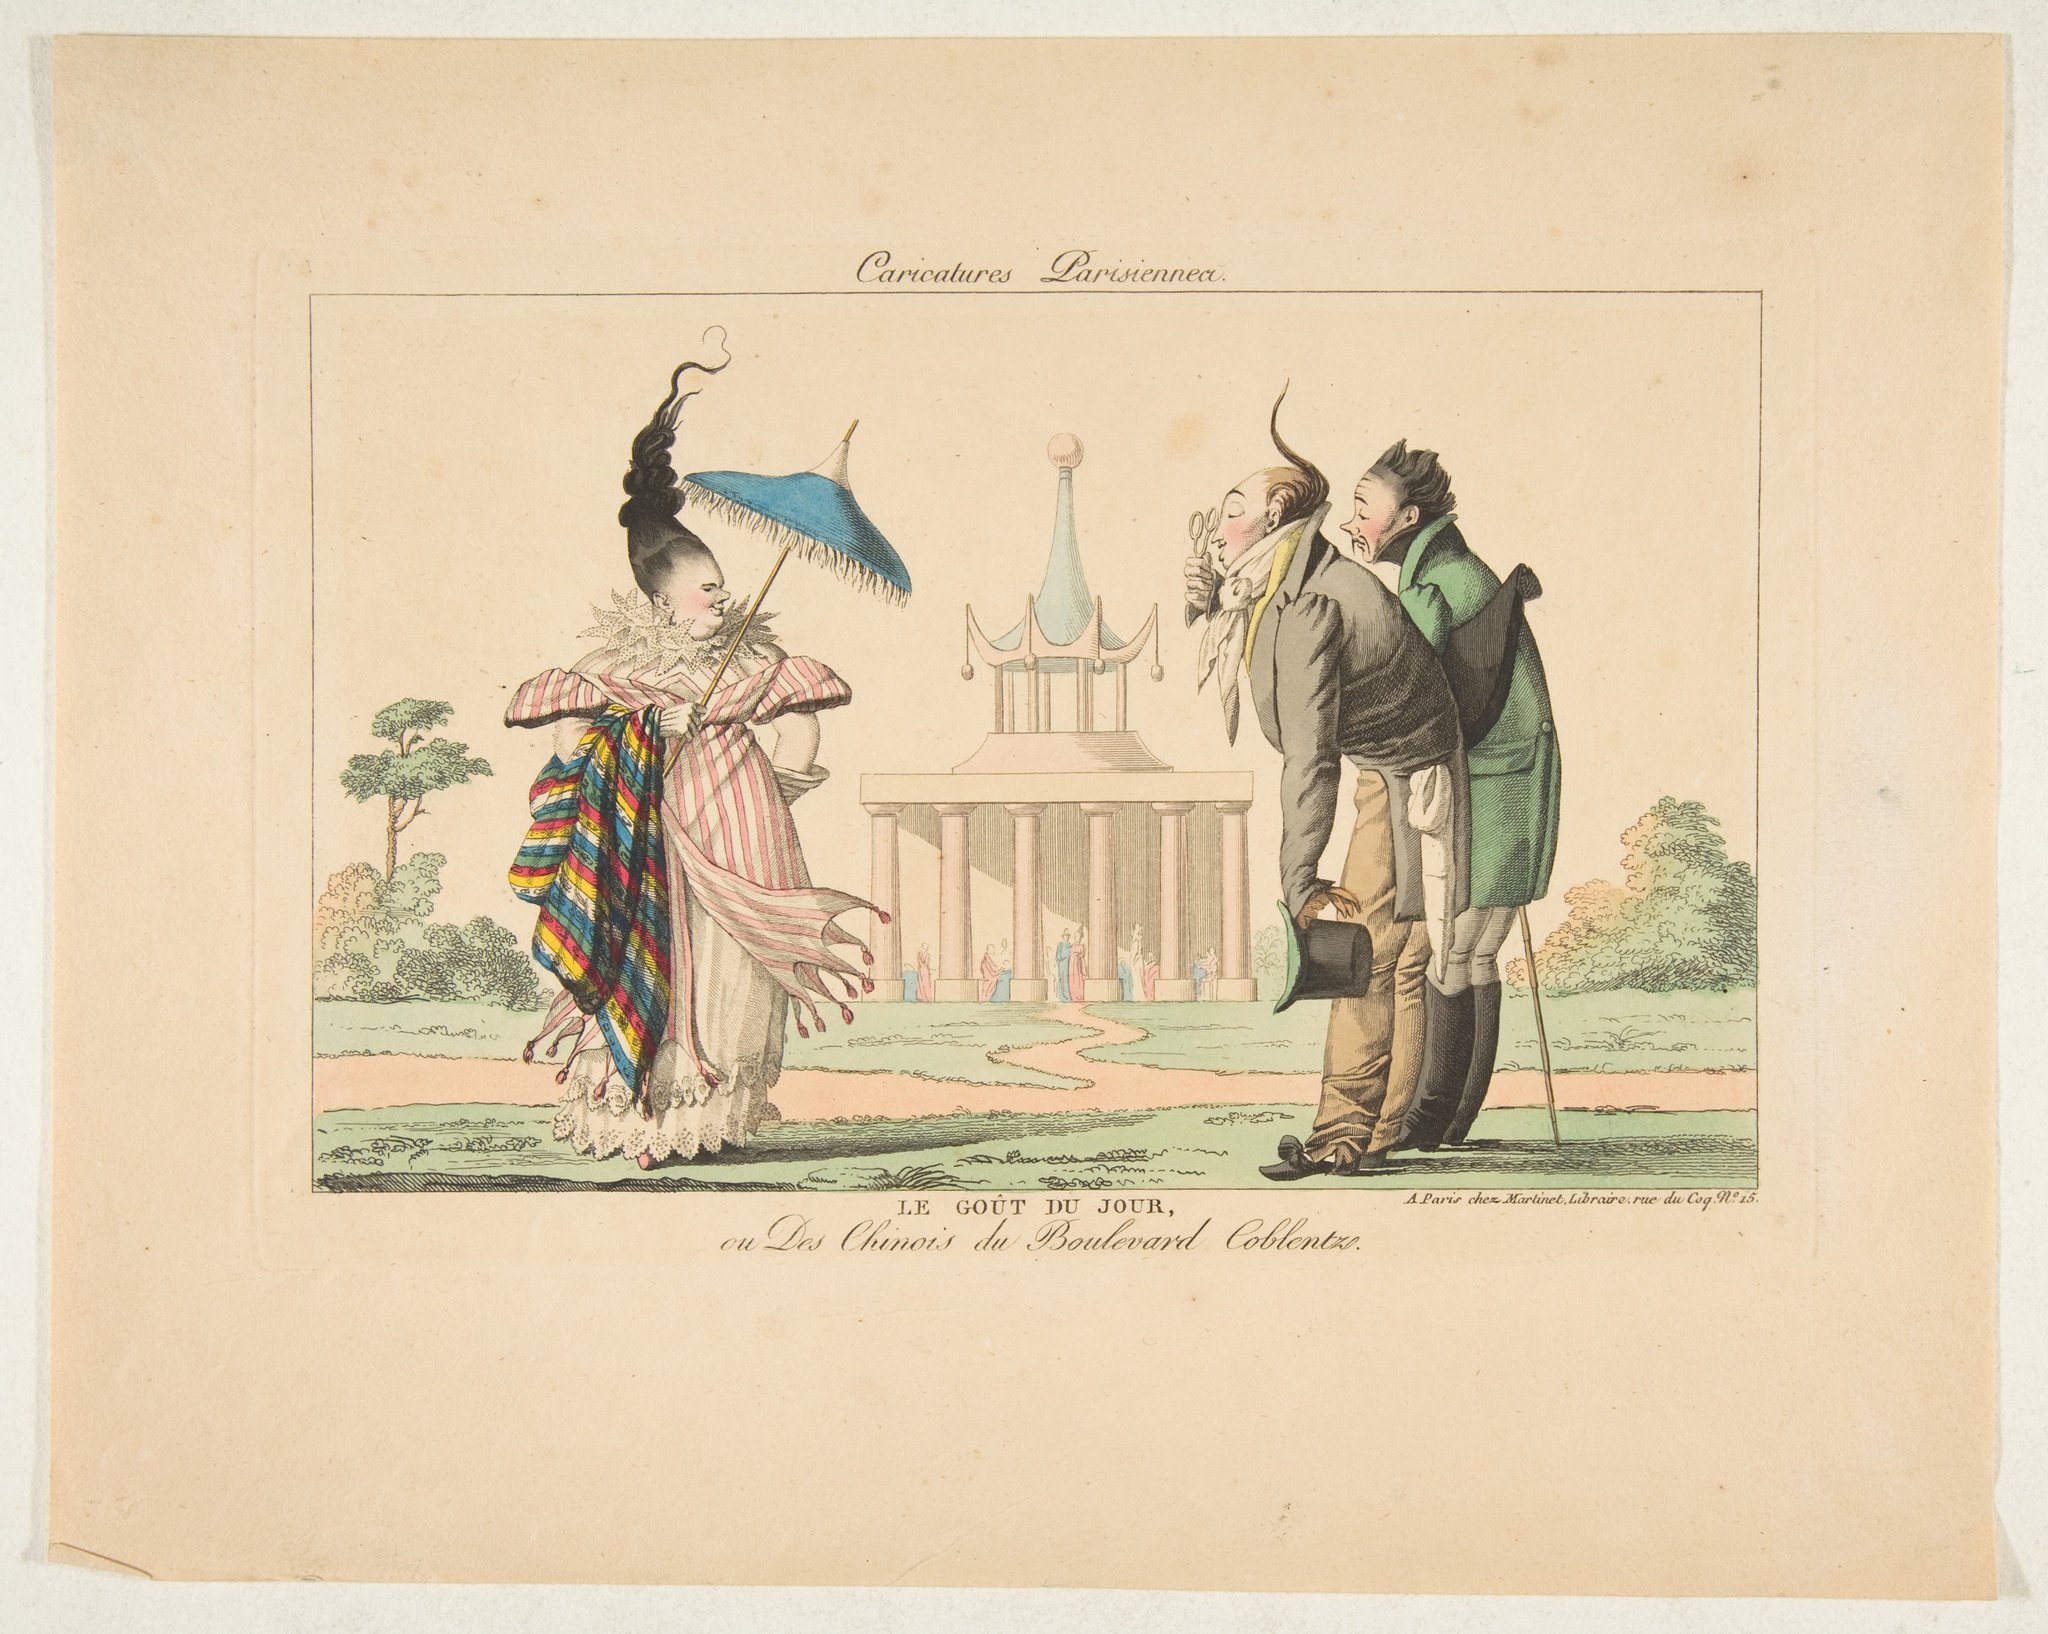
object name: print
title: Le Goût du Jour ou Des Chinois du Boulevard Coblentz, from "Caricatures Parisiennes"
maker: aaron martinet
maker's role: publisher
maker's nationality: french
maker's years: 1762-1841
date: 1815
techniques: etching, hand coloring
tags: satire,men,women